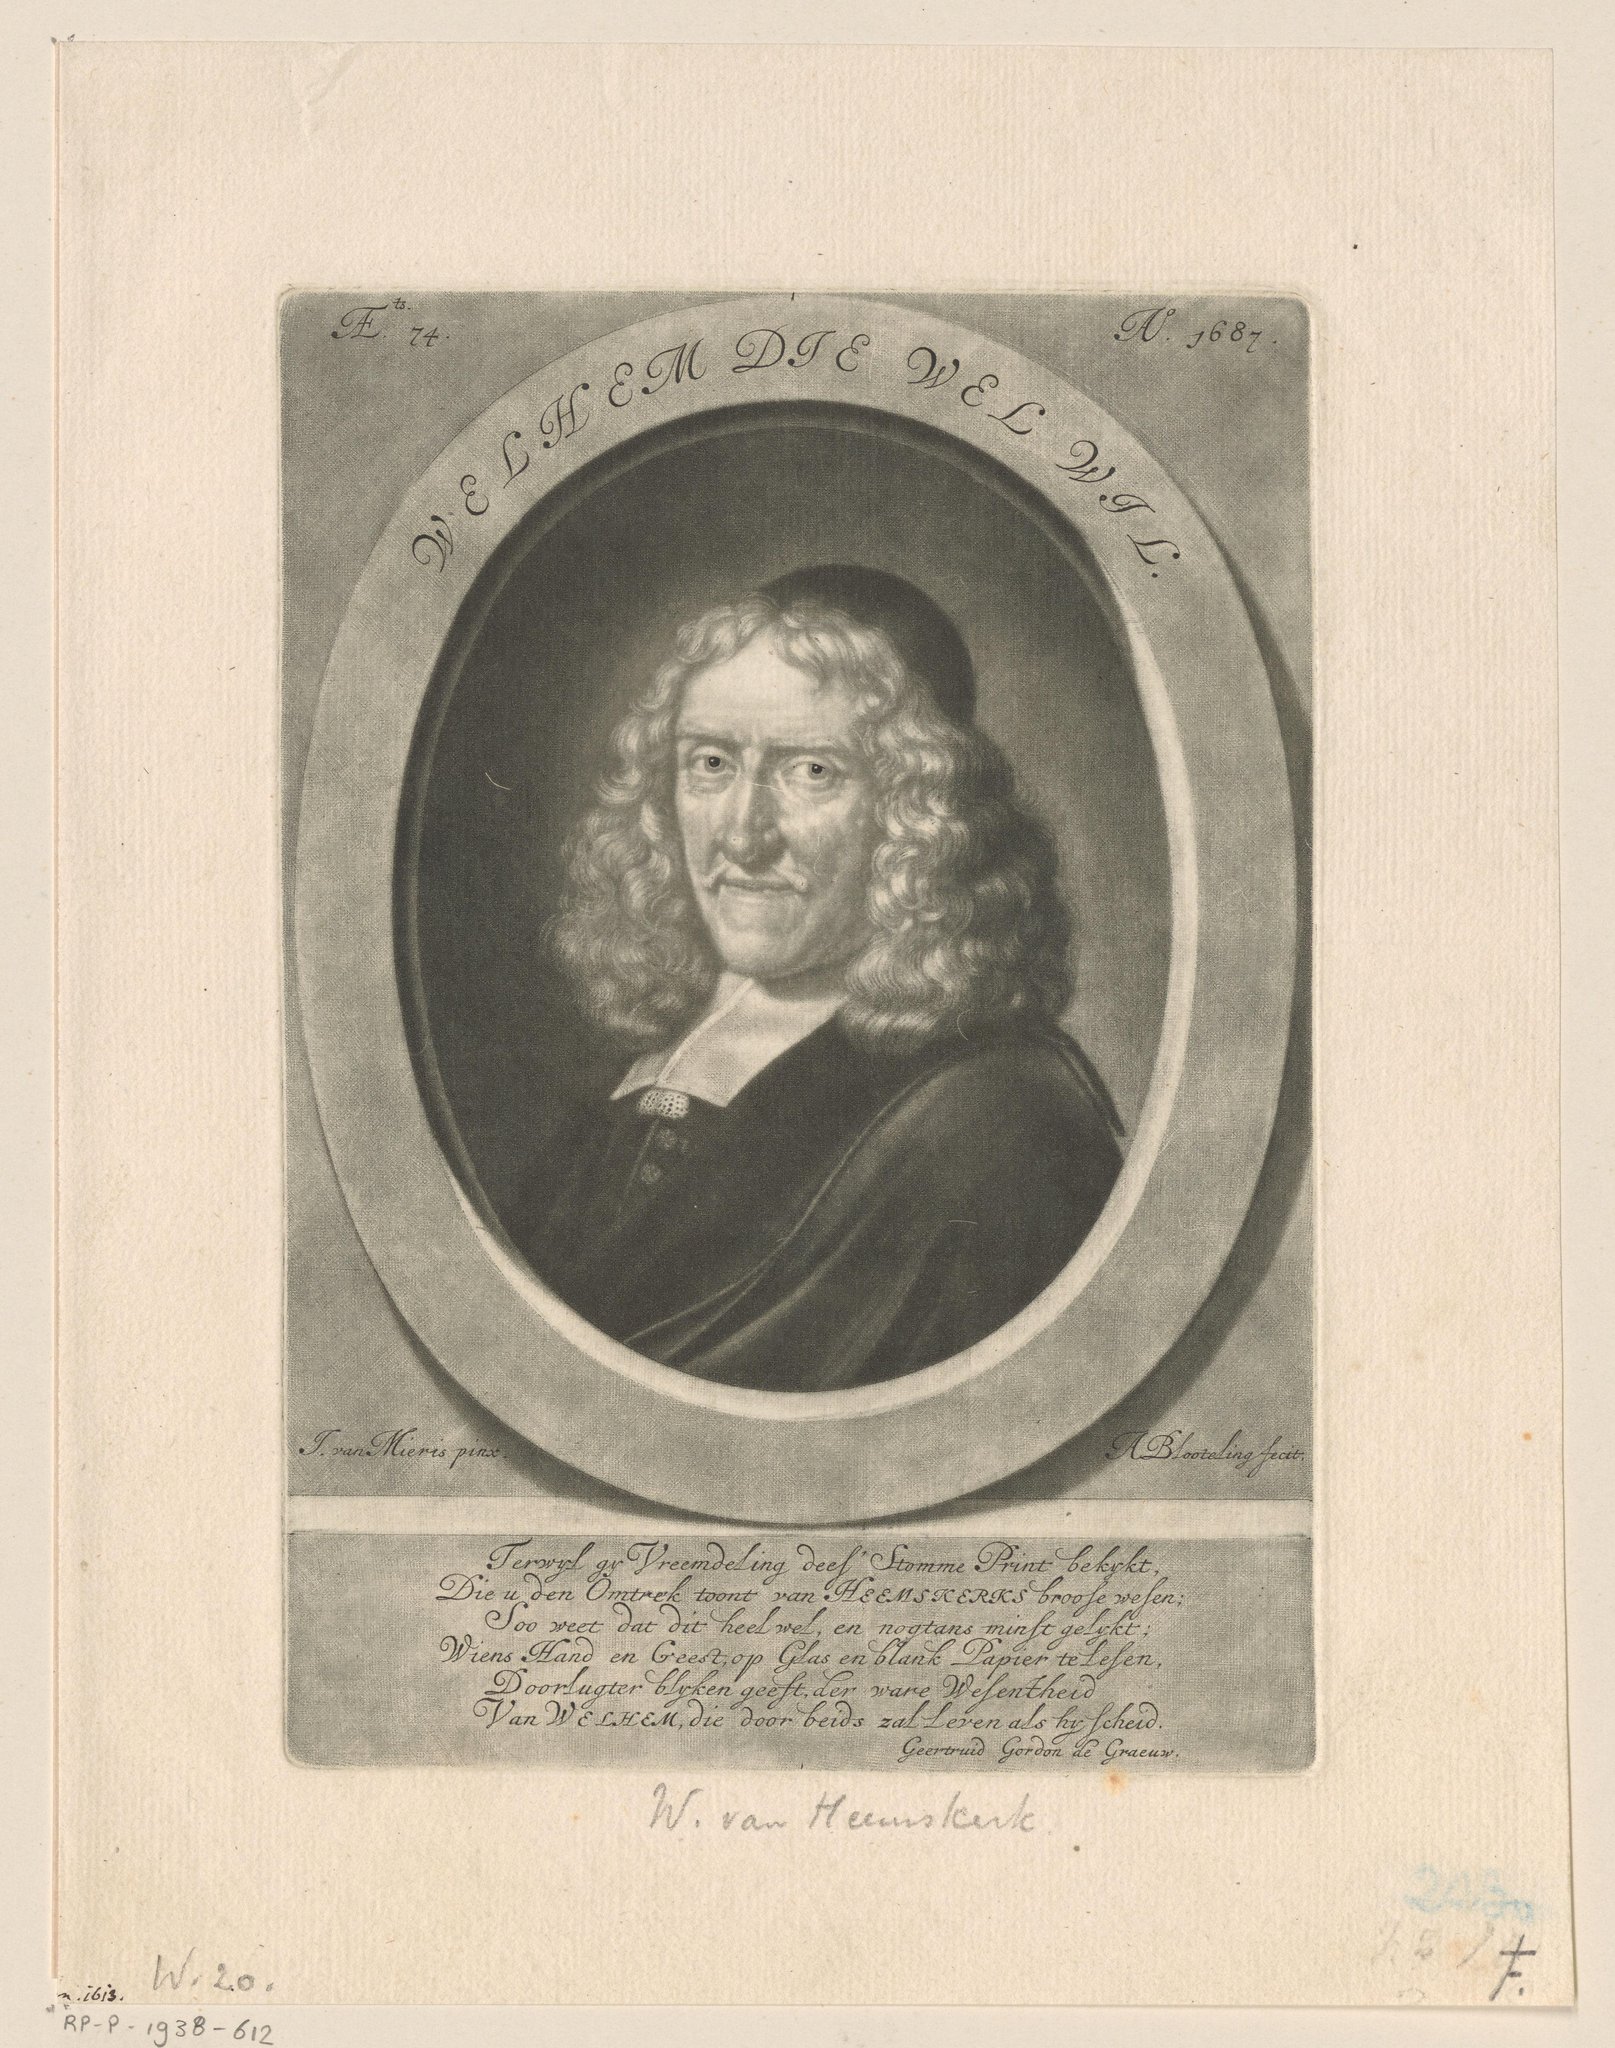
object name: print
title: Portret van Willem Jacobszoon van Heemskerk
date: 1687-1690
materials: paper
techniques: engraving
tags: leiden, willem jacobszoon van heemskerk, historical persons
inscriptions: collector's mark: Lugt 2228